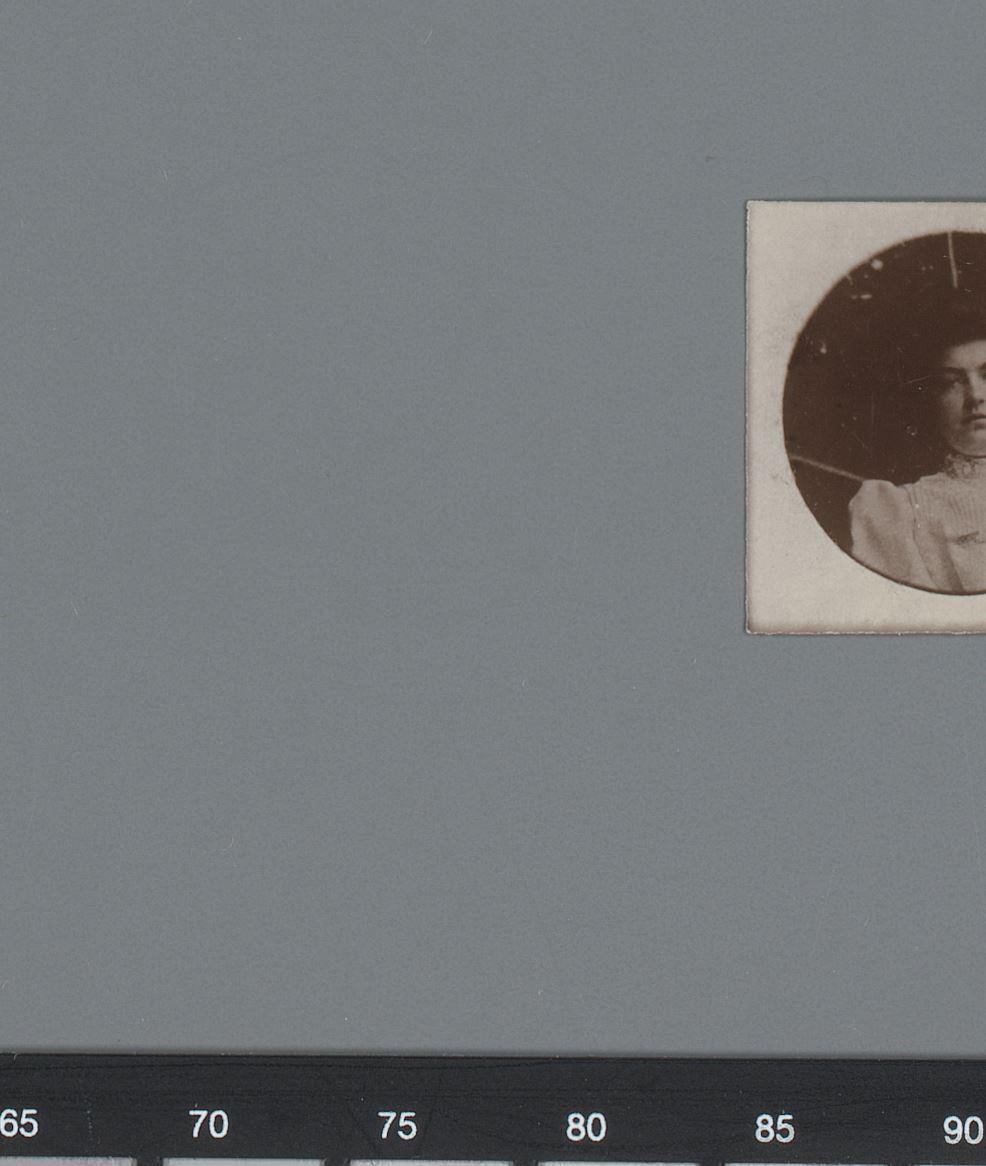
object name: photograph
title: Miniatuurportret van een onbekende vrouw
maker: Anonymous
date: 1890-1930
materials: paper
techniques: gelatin silver print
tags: adolescent, young woman, maiden